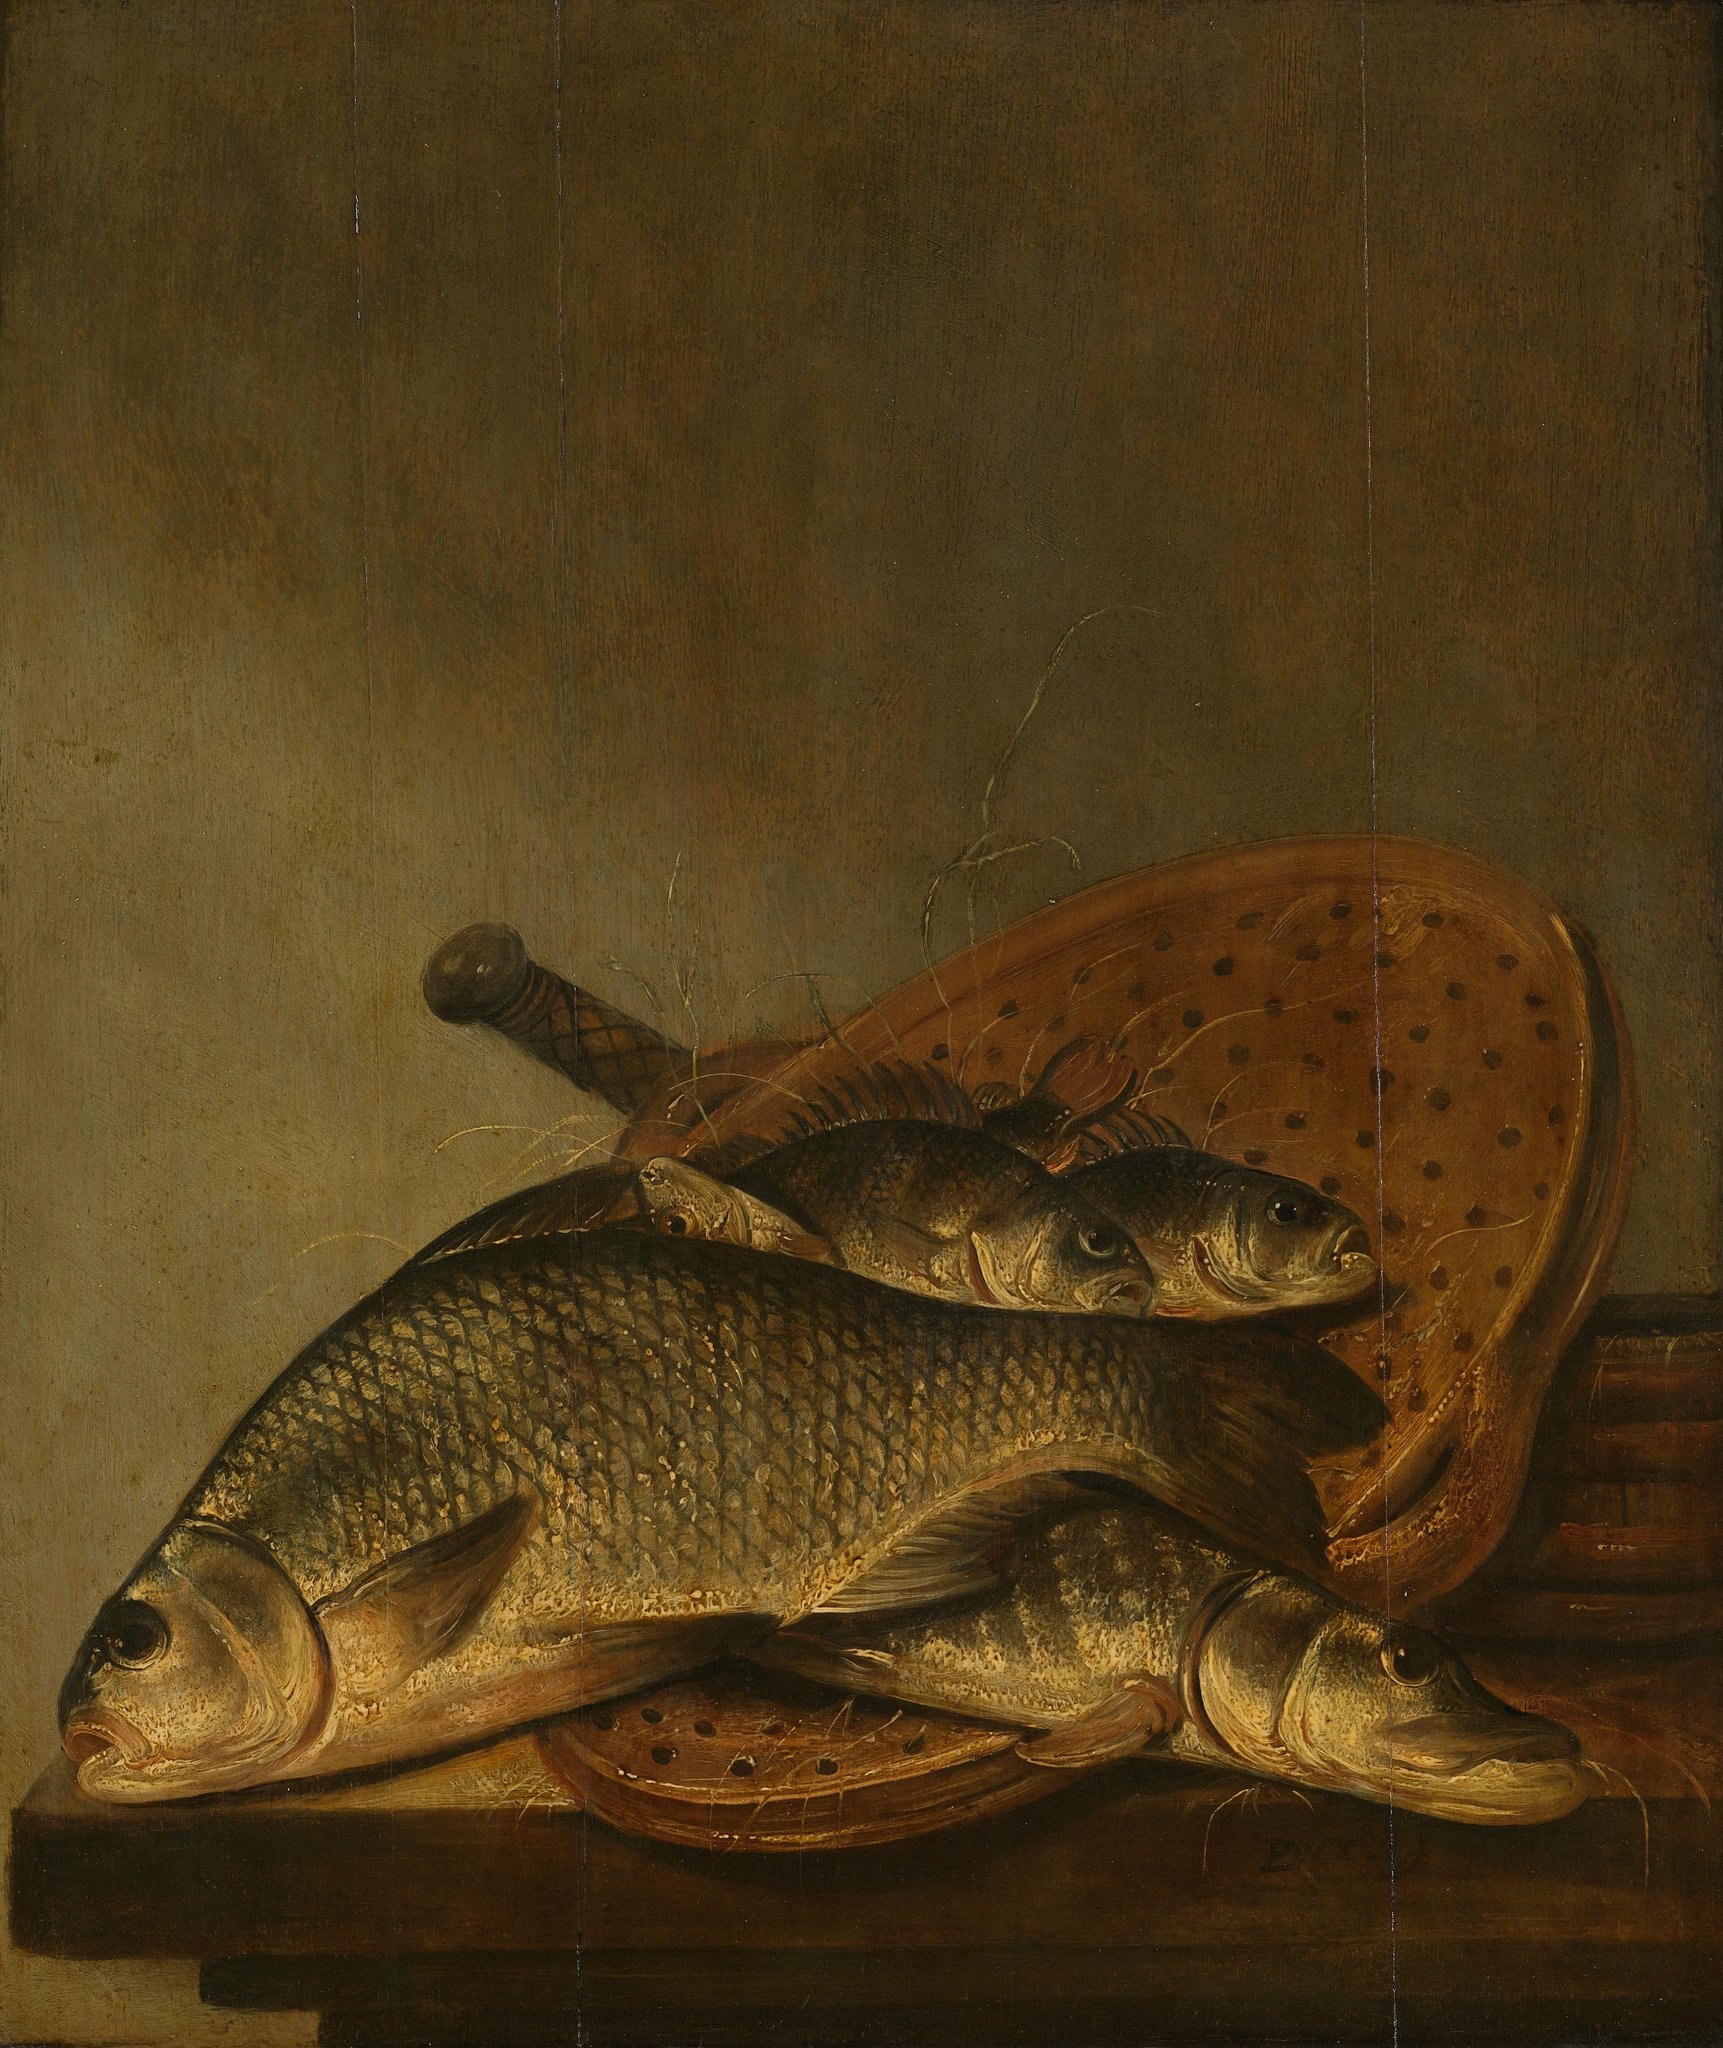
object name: painting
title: Still Life with Fish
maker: pieter de putter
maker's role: painter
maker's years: 1600-1659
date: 1639-1659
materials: oil, panel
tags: fishes, still life of related objects, fish; still life of fishes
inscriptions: signature, bottom right, on the edge of the table: ‘P D V T r f’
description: Visstilleven. Op de hoek van een houten tafel liggen enkele verschillende soorten vissen op een aardewerken vergiet.